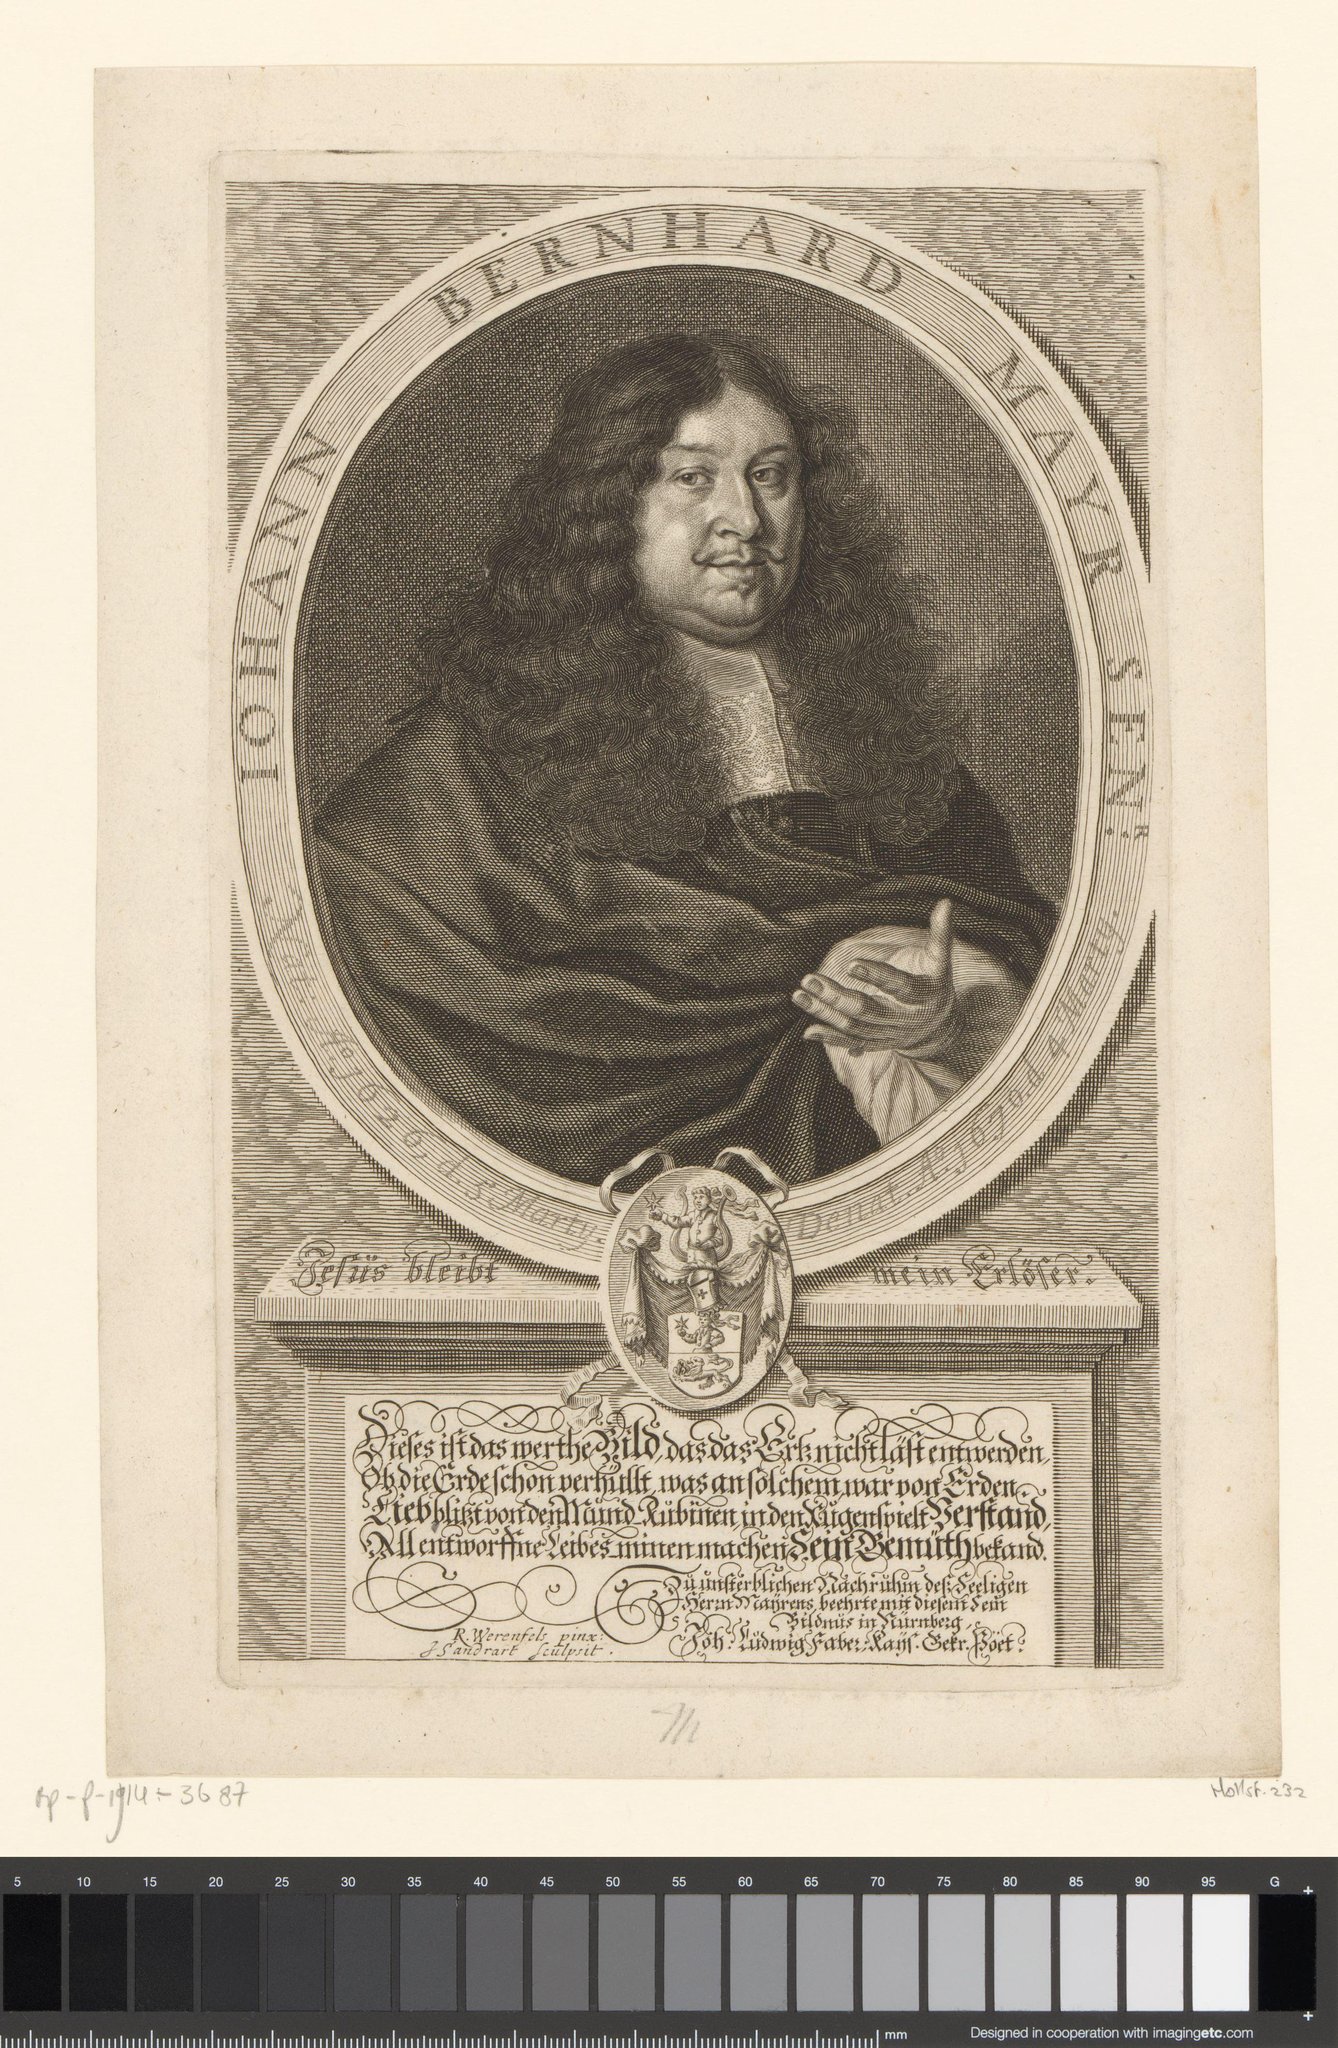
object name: print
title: Portret van Johann Bernhard Mayr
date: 1670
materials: paper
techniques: engraving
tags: historical persons, armorial bearing, heraldry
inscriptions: collector's mark: Lugt 2228